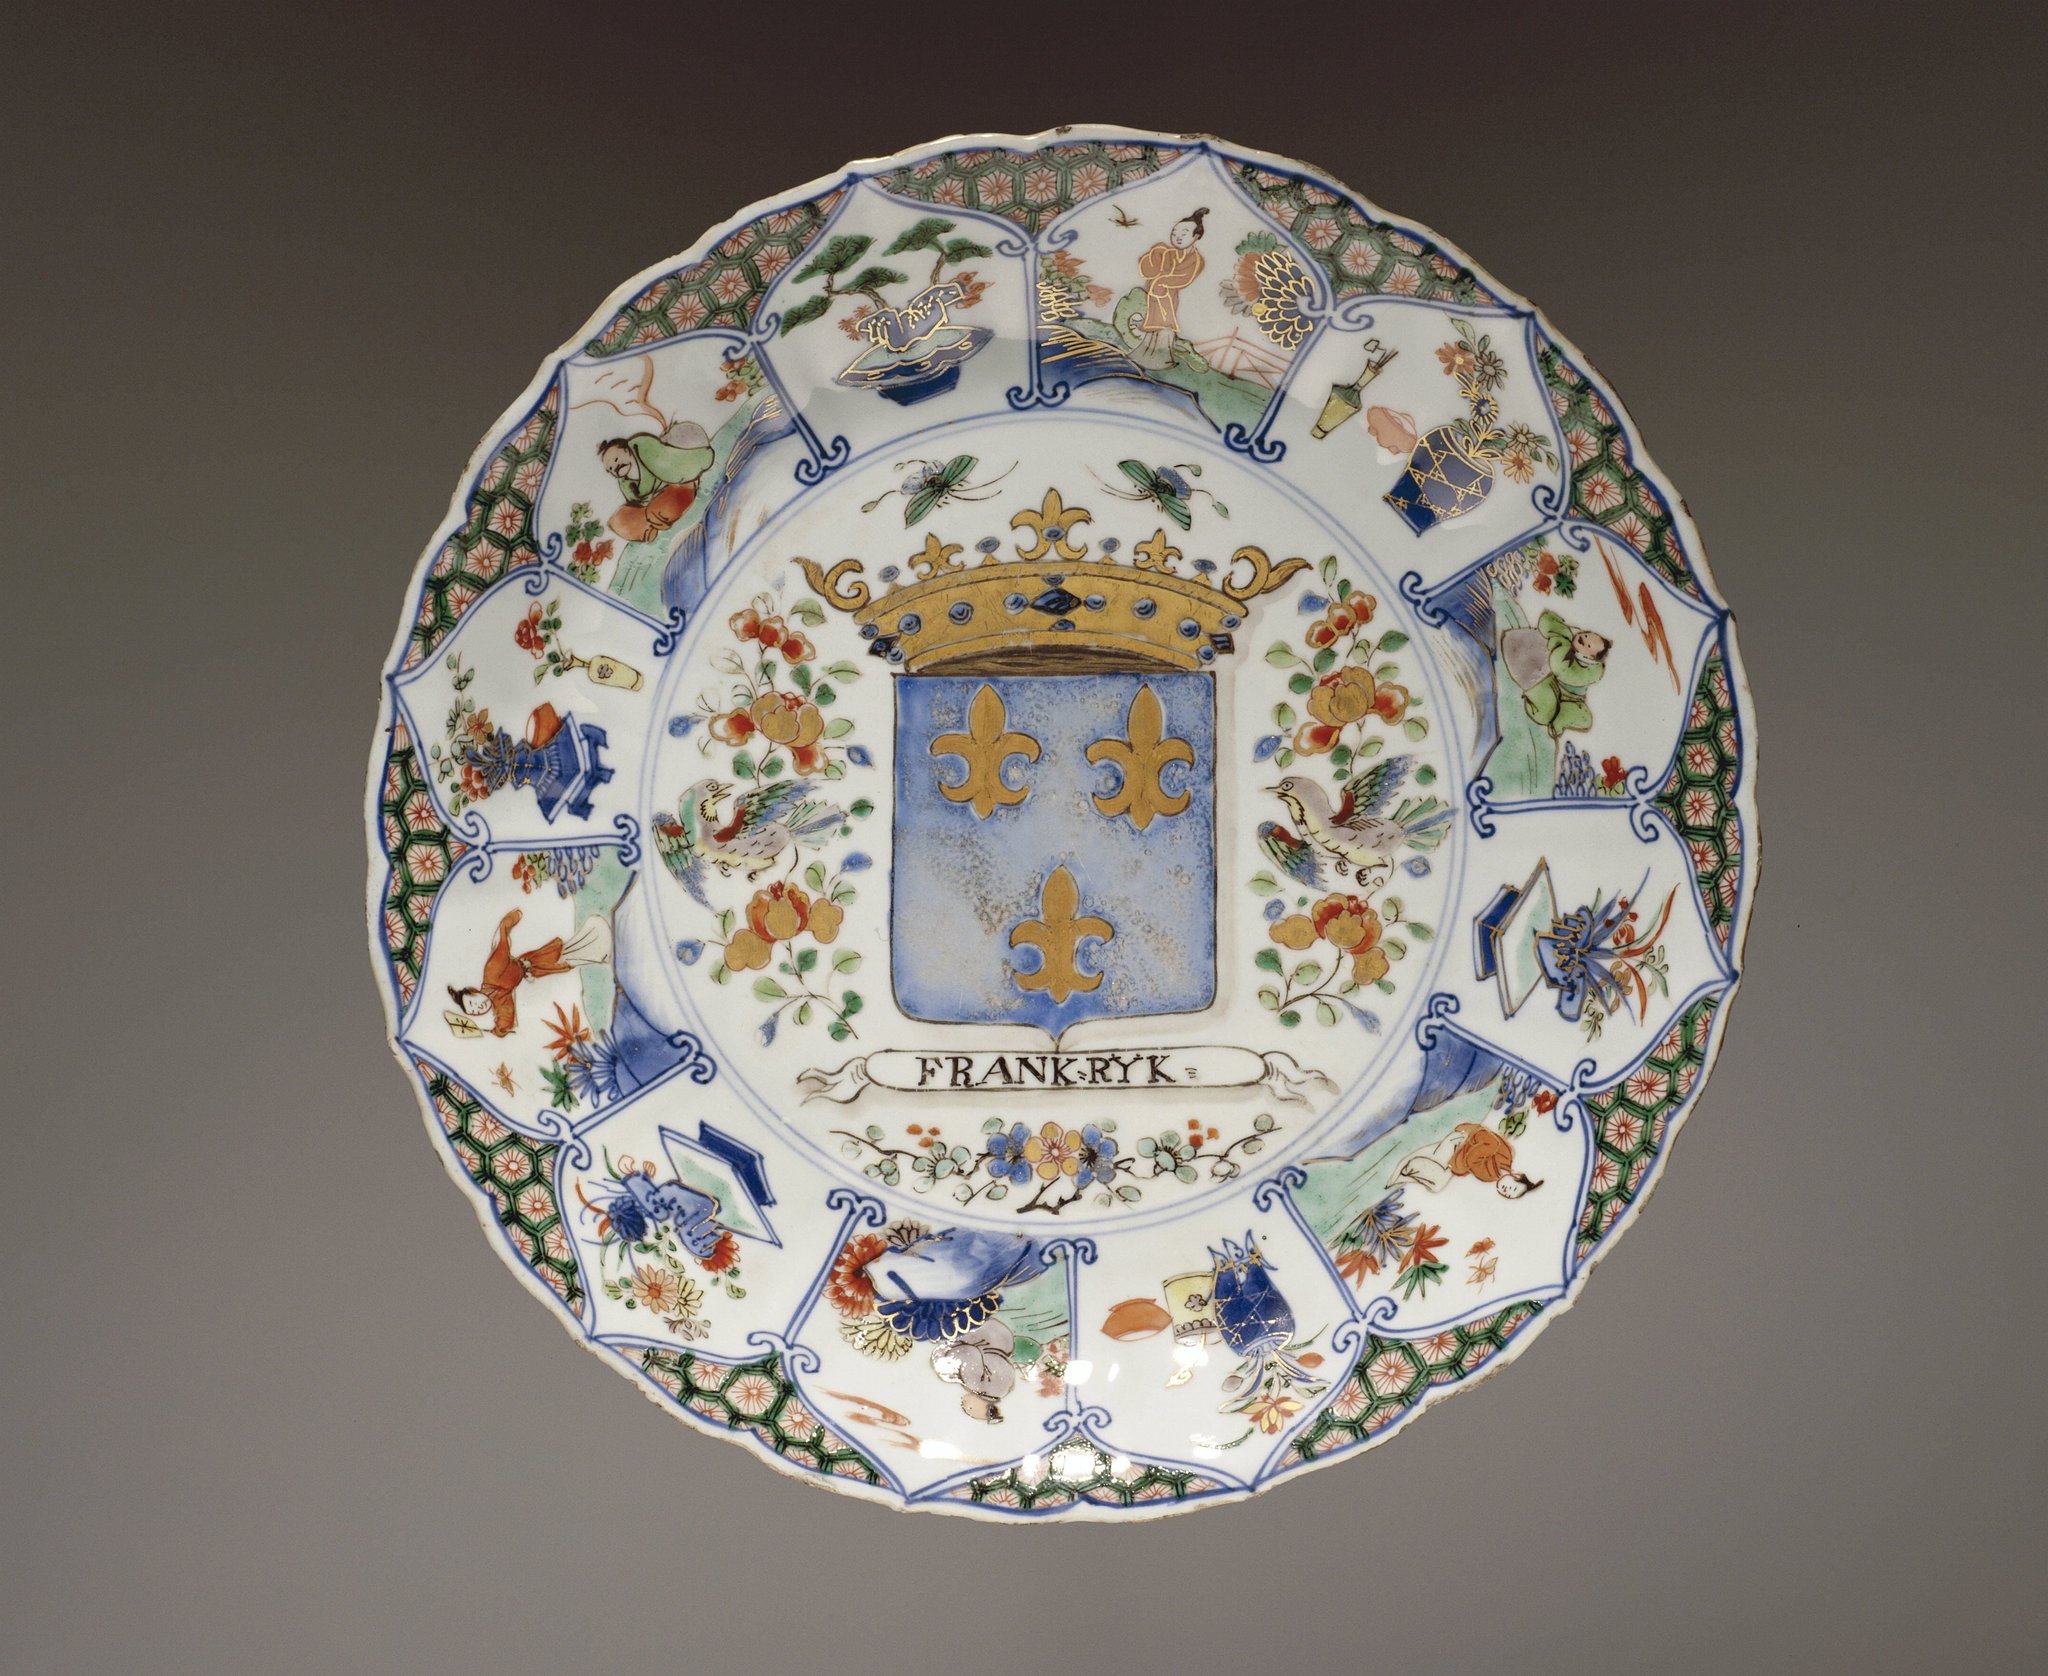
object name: platter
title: Saucer-dish with the arms of France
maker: Anonymous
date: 1700-1724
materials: cobalt, glaze, gold, paint, porcelain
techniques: firing, gilding, turning, vitrification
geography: china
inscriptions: inscription: ‘Frankryk’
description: Schotel van porselein met geribde wand en geschulpte rand, beschilderd in onderglazuur blauw en op het glazuur blauw, rood, groen, geel, zwart en goud. Op het plat in een medaillon het wapen van Frankrijk met daaronder het opschrift 'Frankryk', om het wapen bloemtakken, twee vlinders en twee vogels. De wand is verdeeld in twaalf bloembladvormige vakken met afwisselend een bloemenvaas en een persoon in een landschap; tussen de vakken servetwerk. De achterzijde met twee bloemtakken. Enkele chips in de rand. Wapenporselein met famille verte emailkleuren.